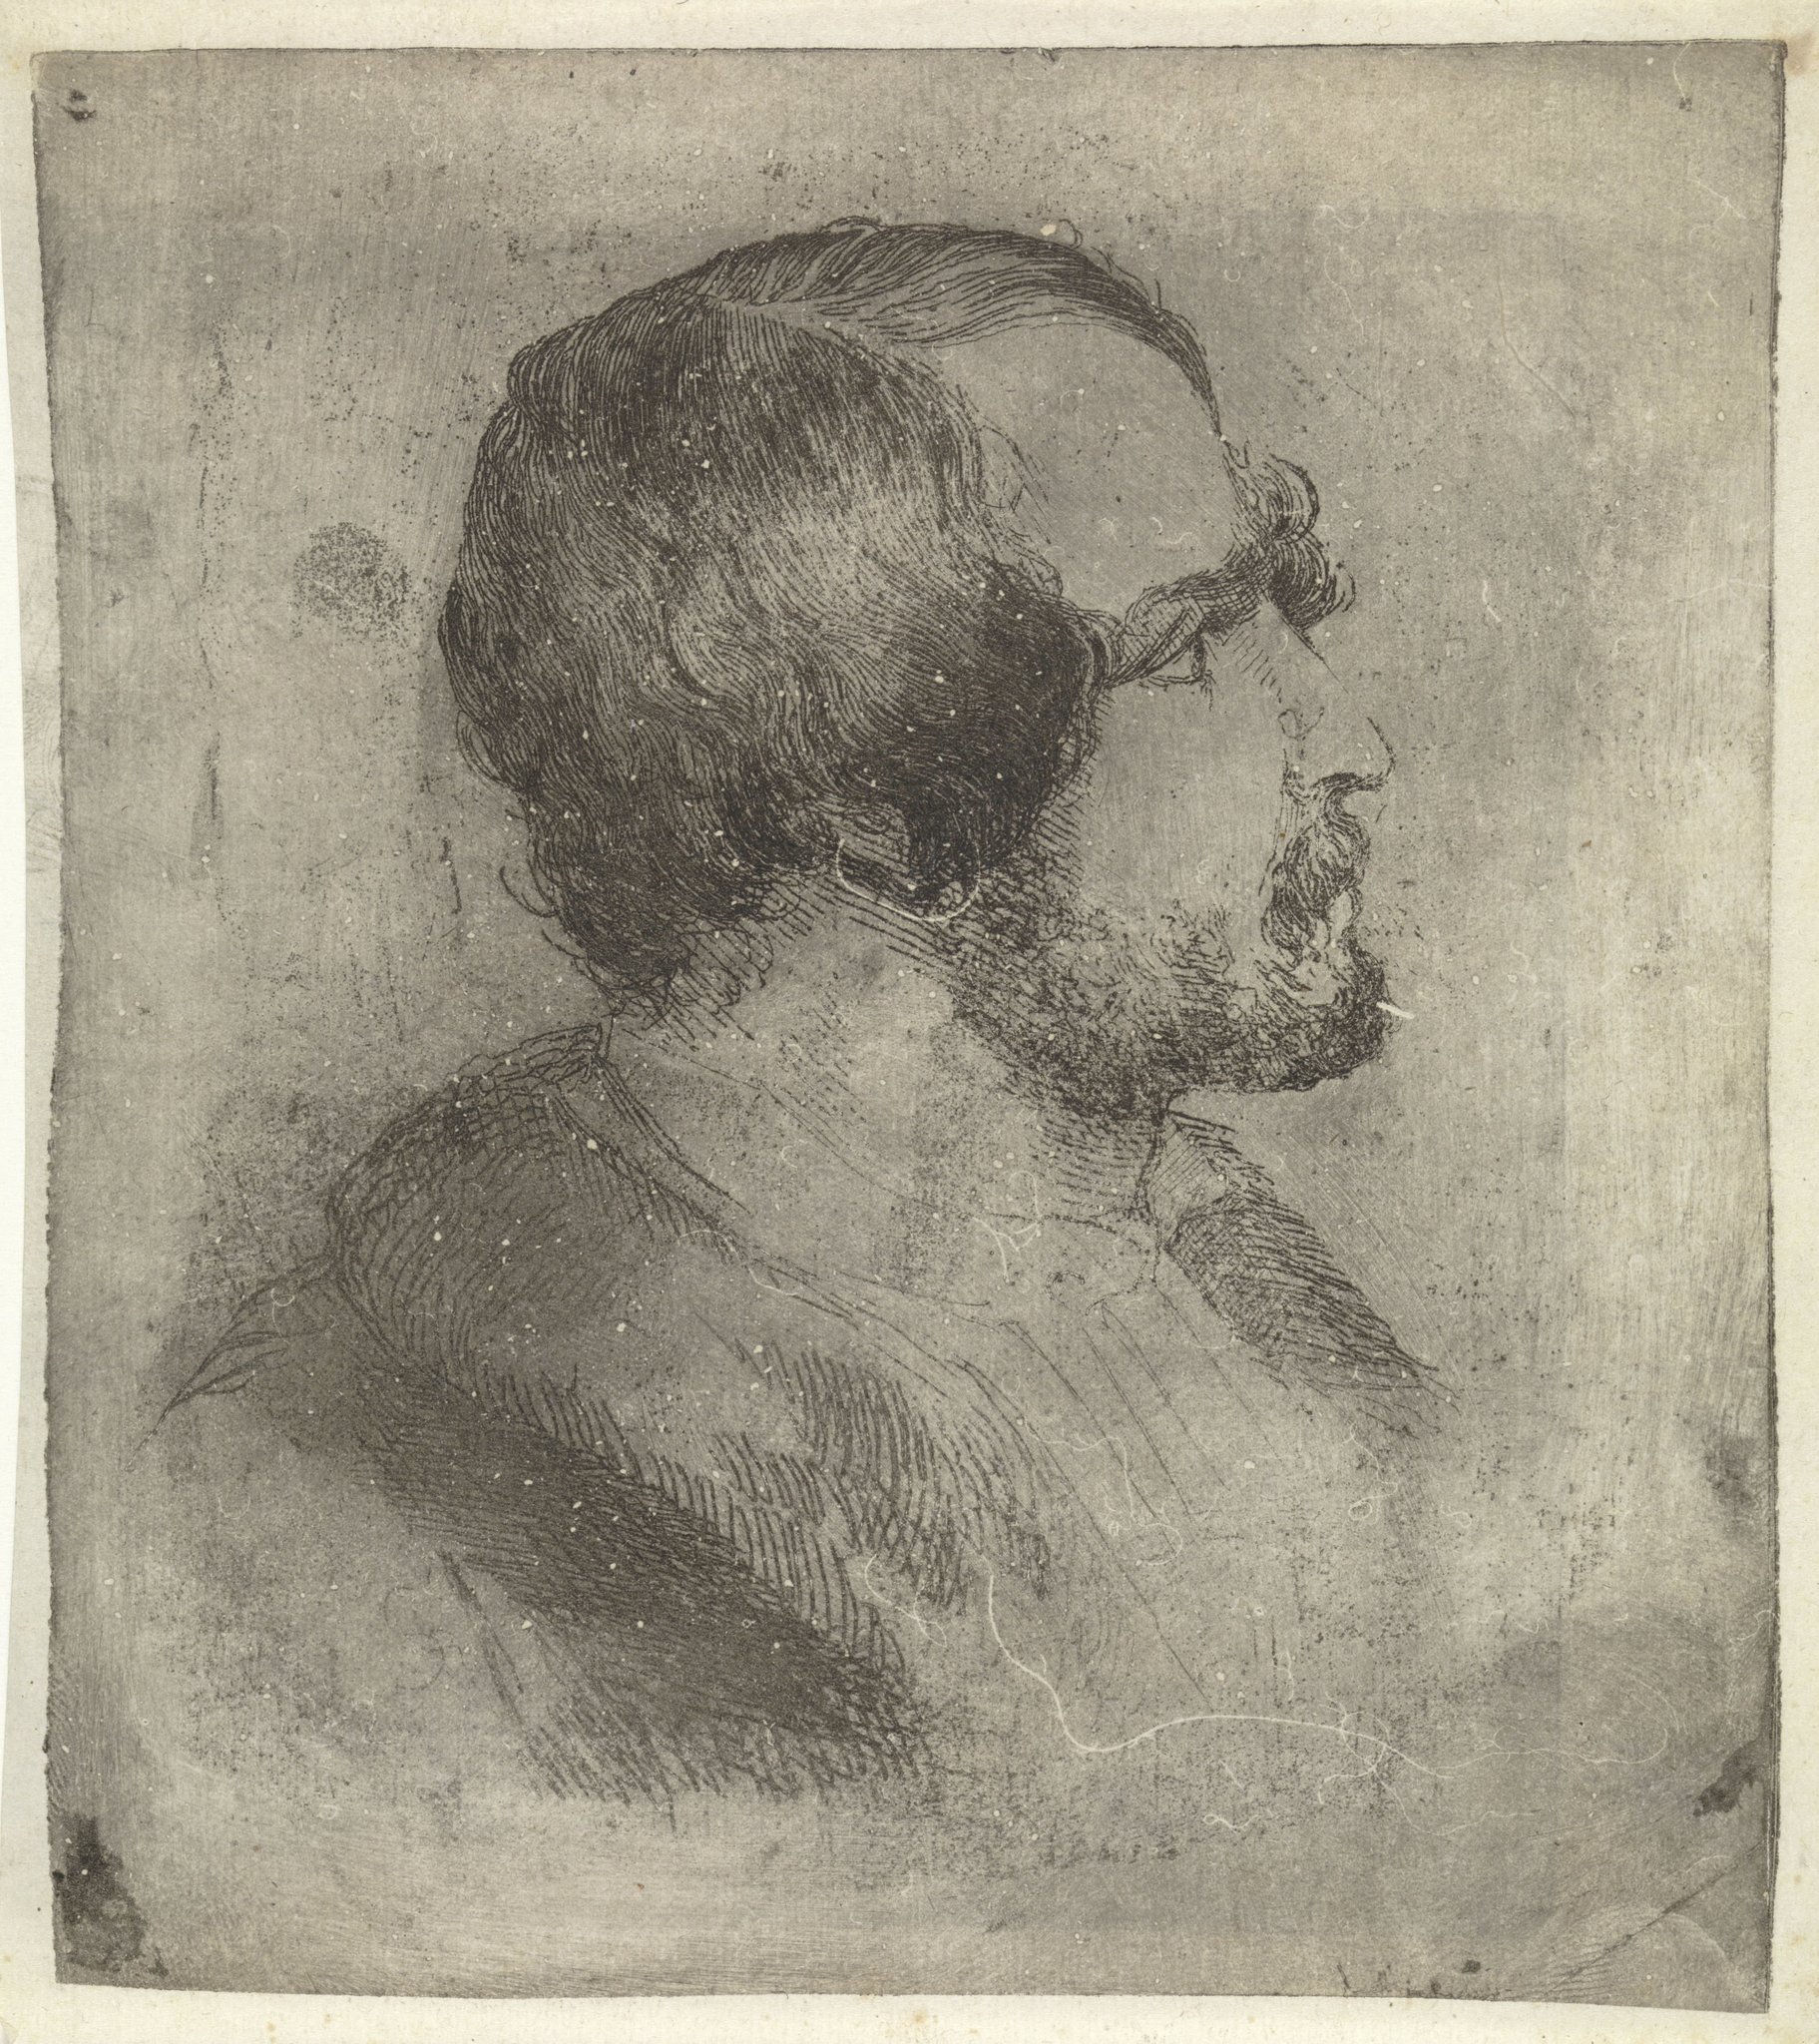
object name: print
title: Portret van prentmaker Alexander Schaepkens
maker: arnoud schaepkens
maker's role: print maker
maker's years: 1816-1904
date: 1831-1904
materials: paper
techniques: etching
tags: maastricht, print maker, draughtsman, alexander schaepkens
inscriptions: collector's mark: Lugt 2228